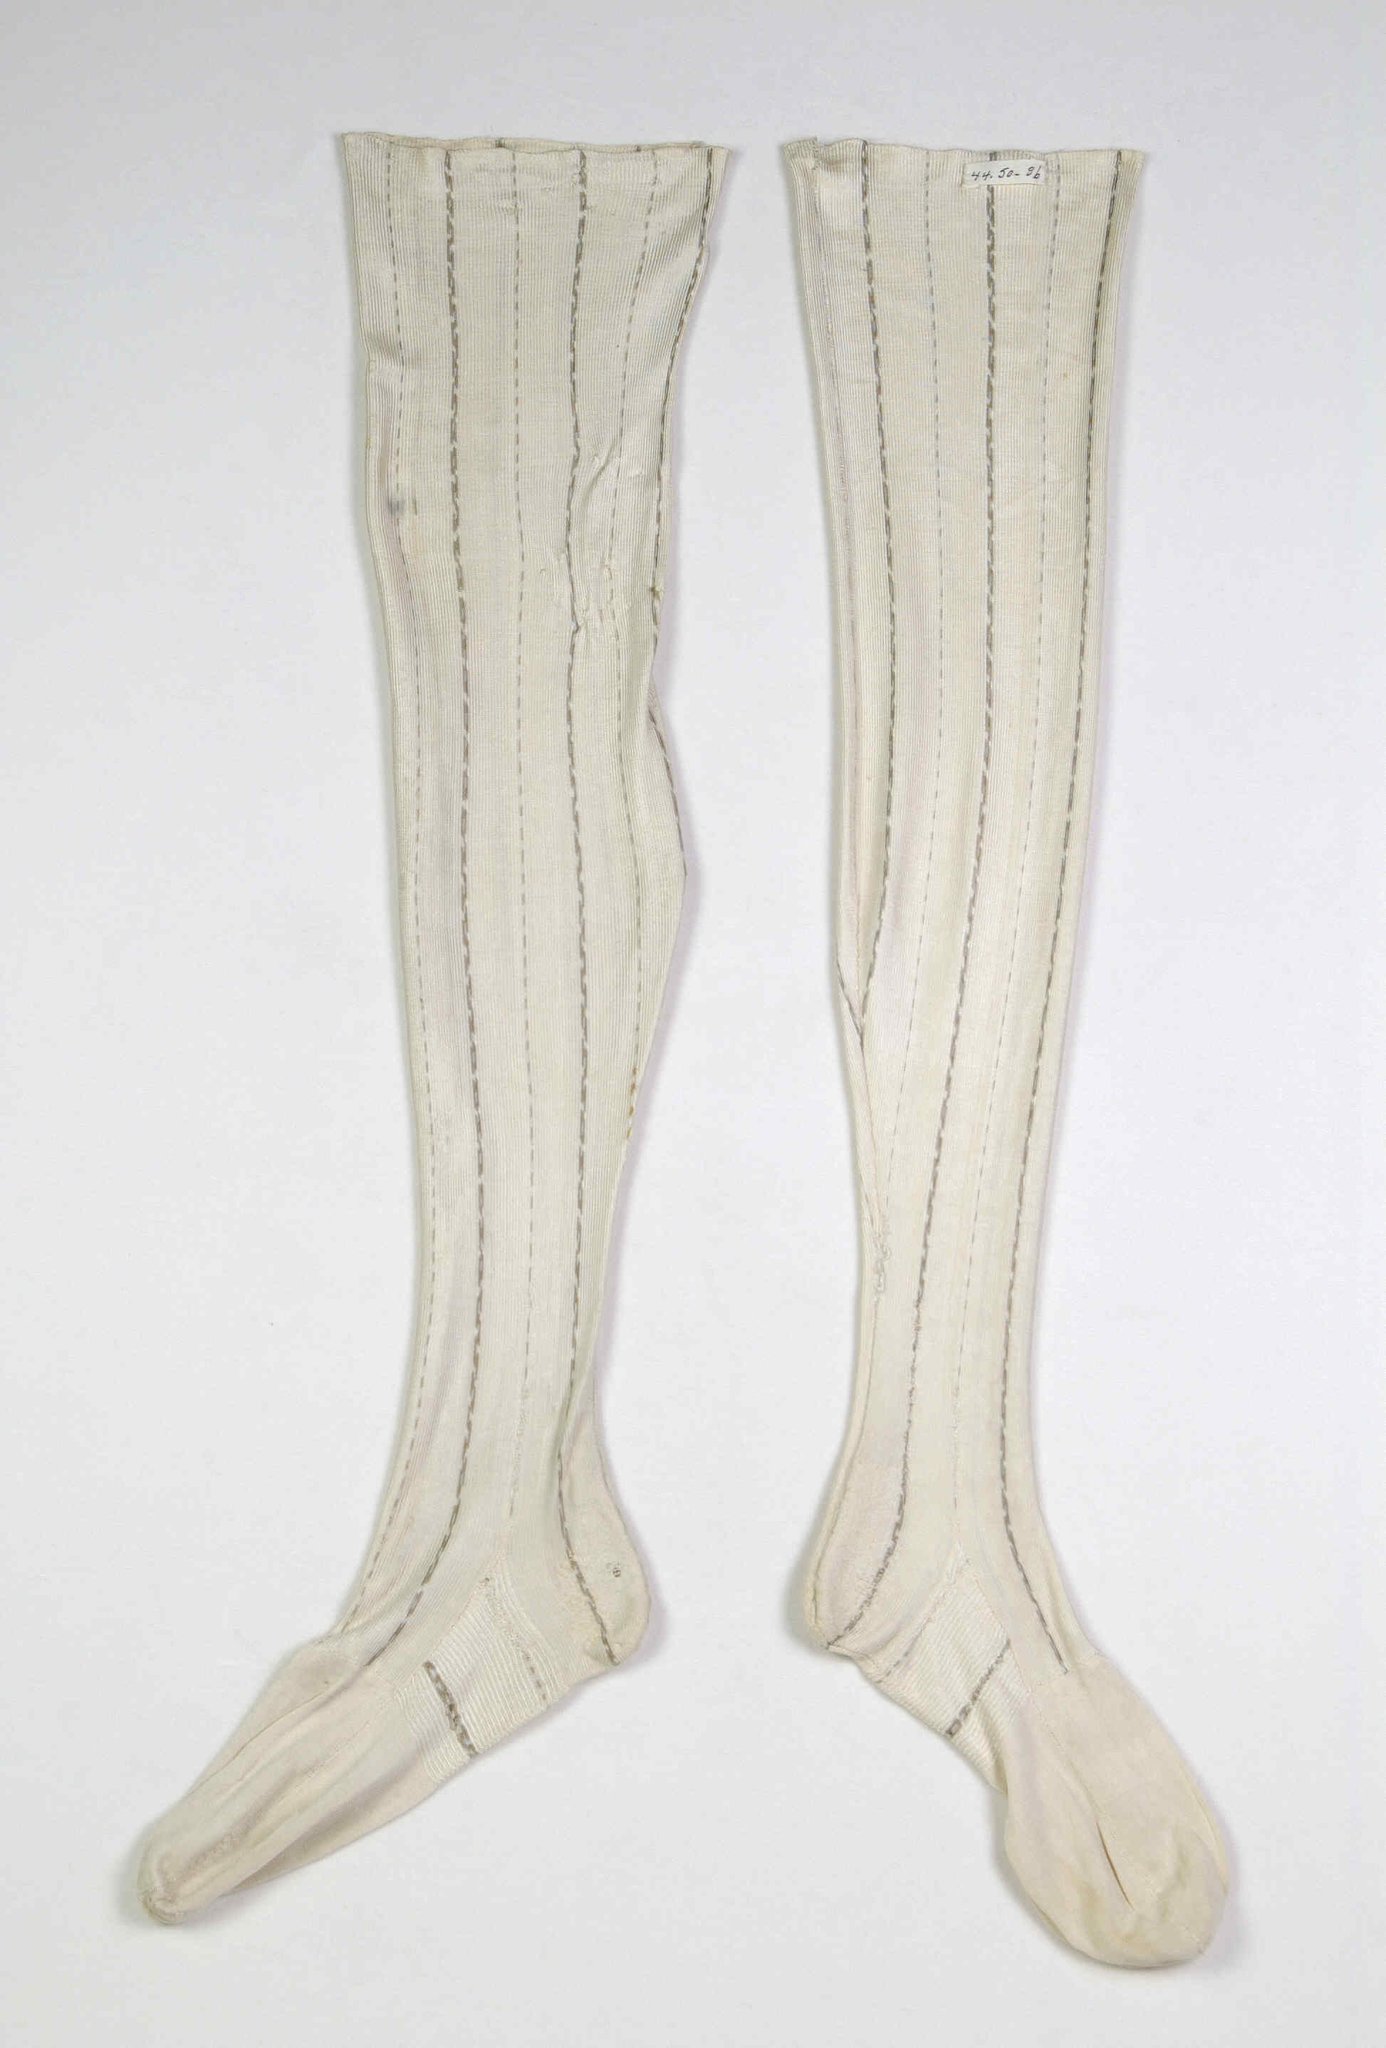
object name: stocking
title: Stockings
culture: american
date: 1870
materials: silk